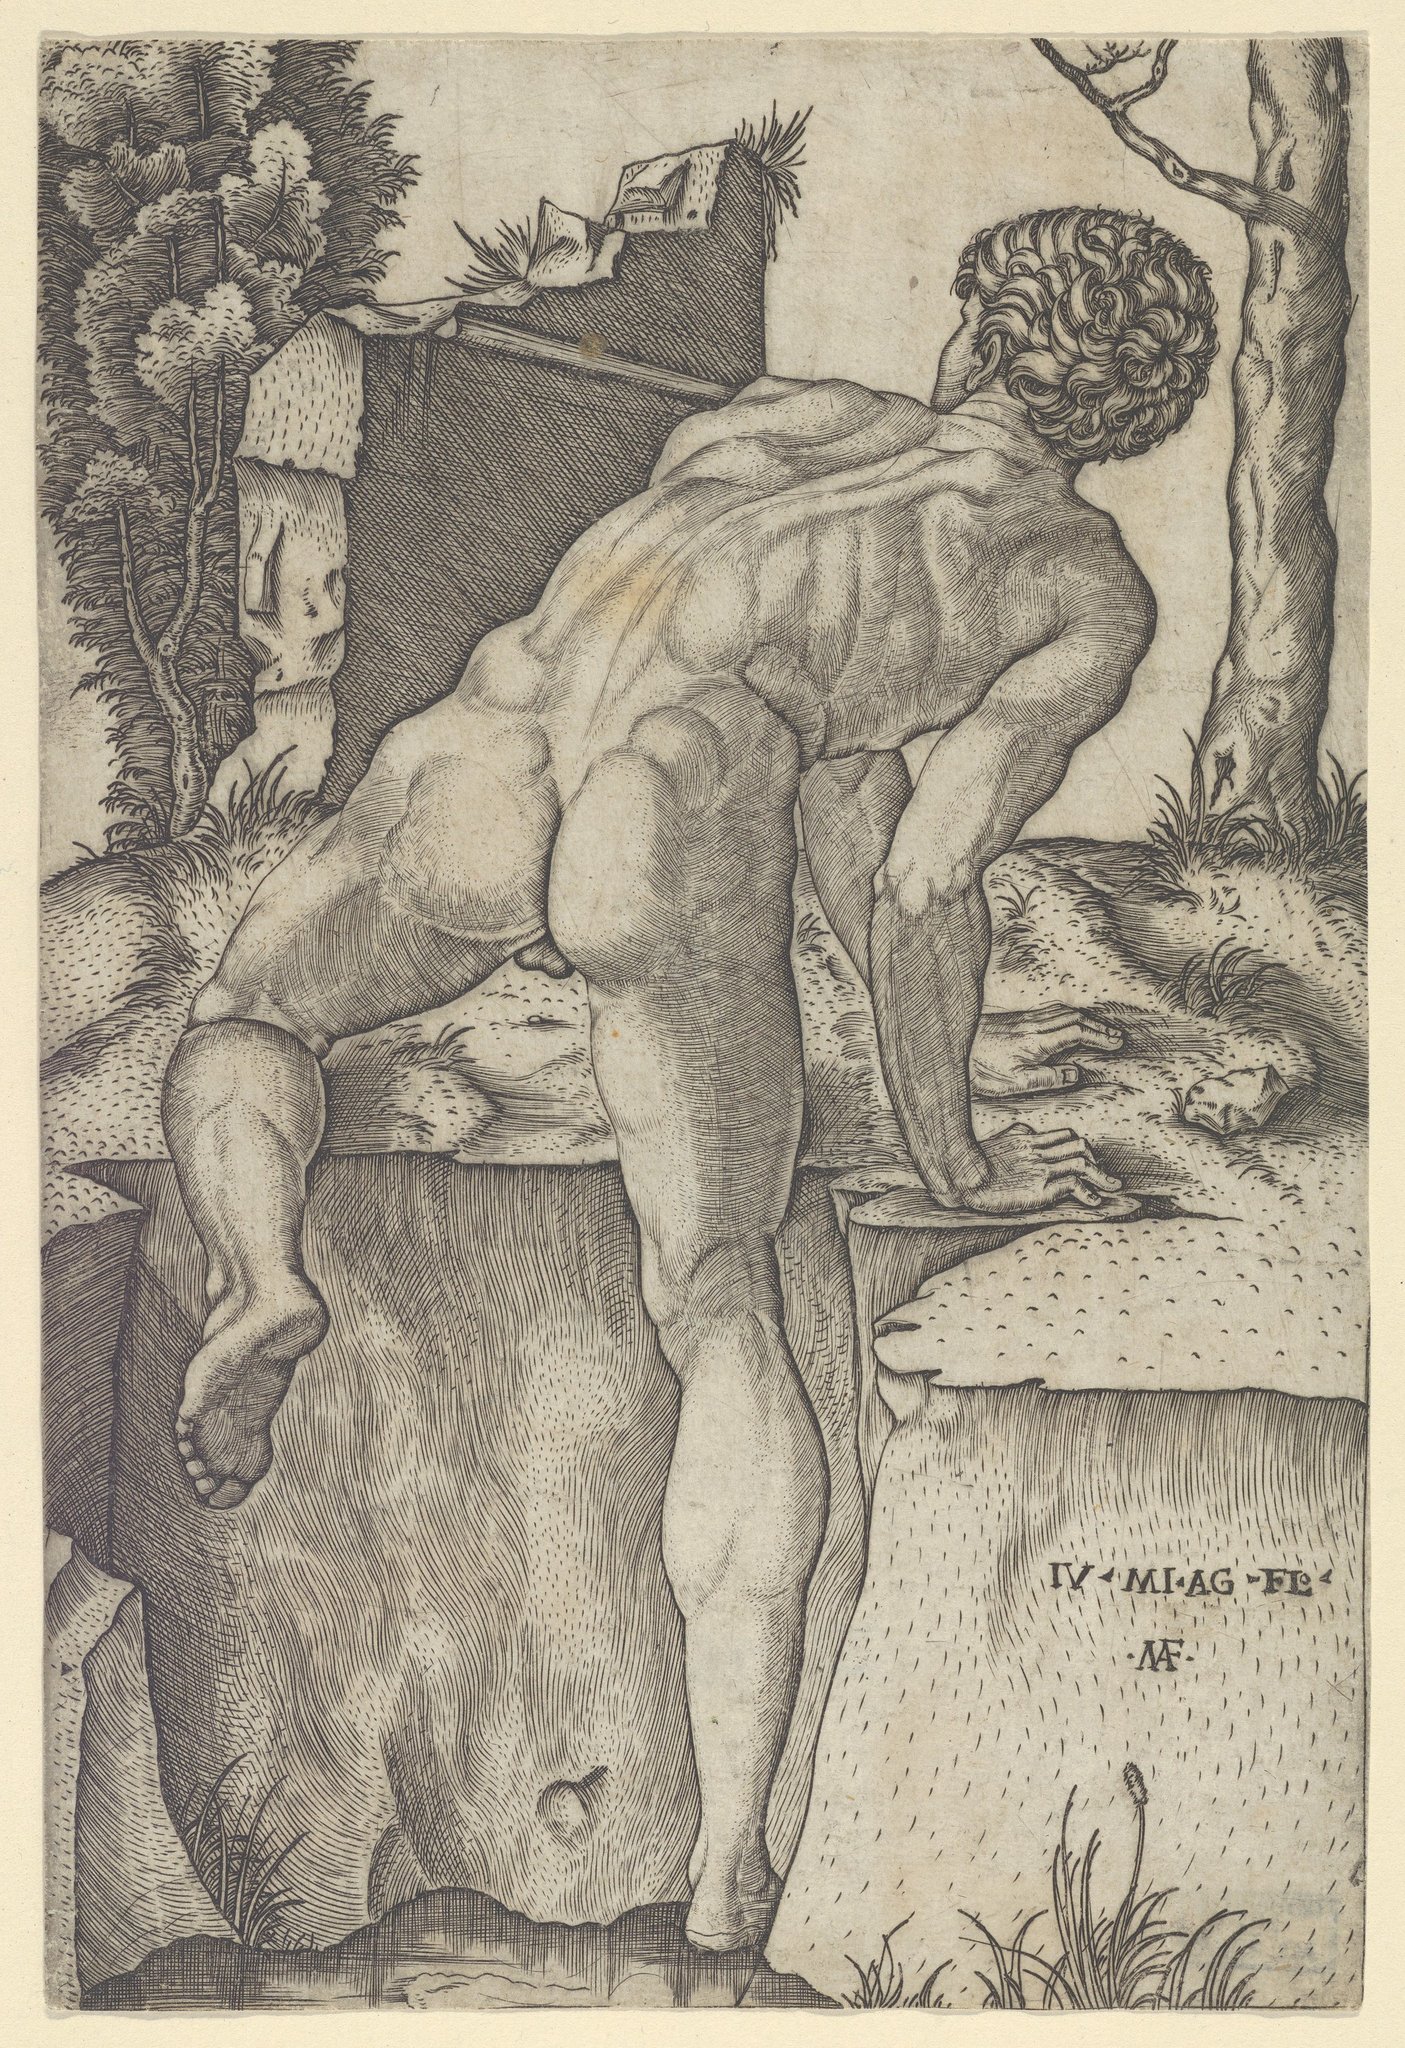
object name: print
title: Naked man viewed from behind climbing a river bank, after Michelangelo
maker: marcantonio raimondi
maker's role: artist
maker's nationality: italian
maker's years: 1475-1534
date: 1500-1534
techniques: engraving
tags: male nudes,trees